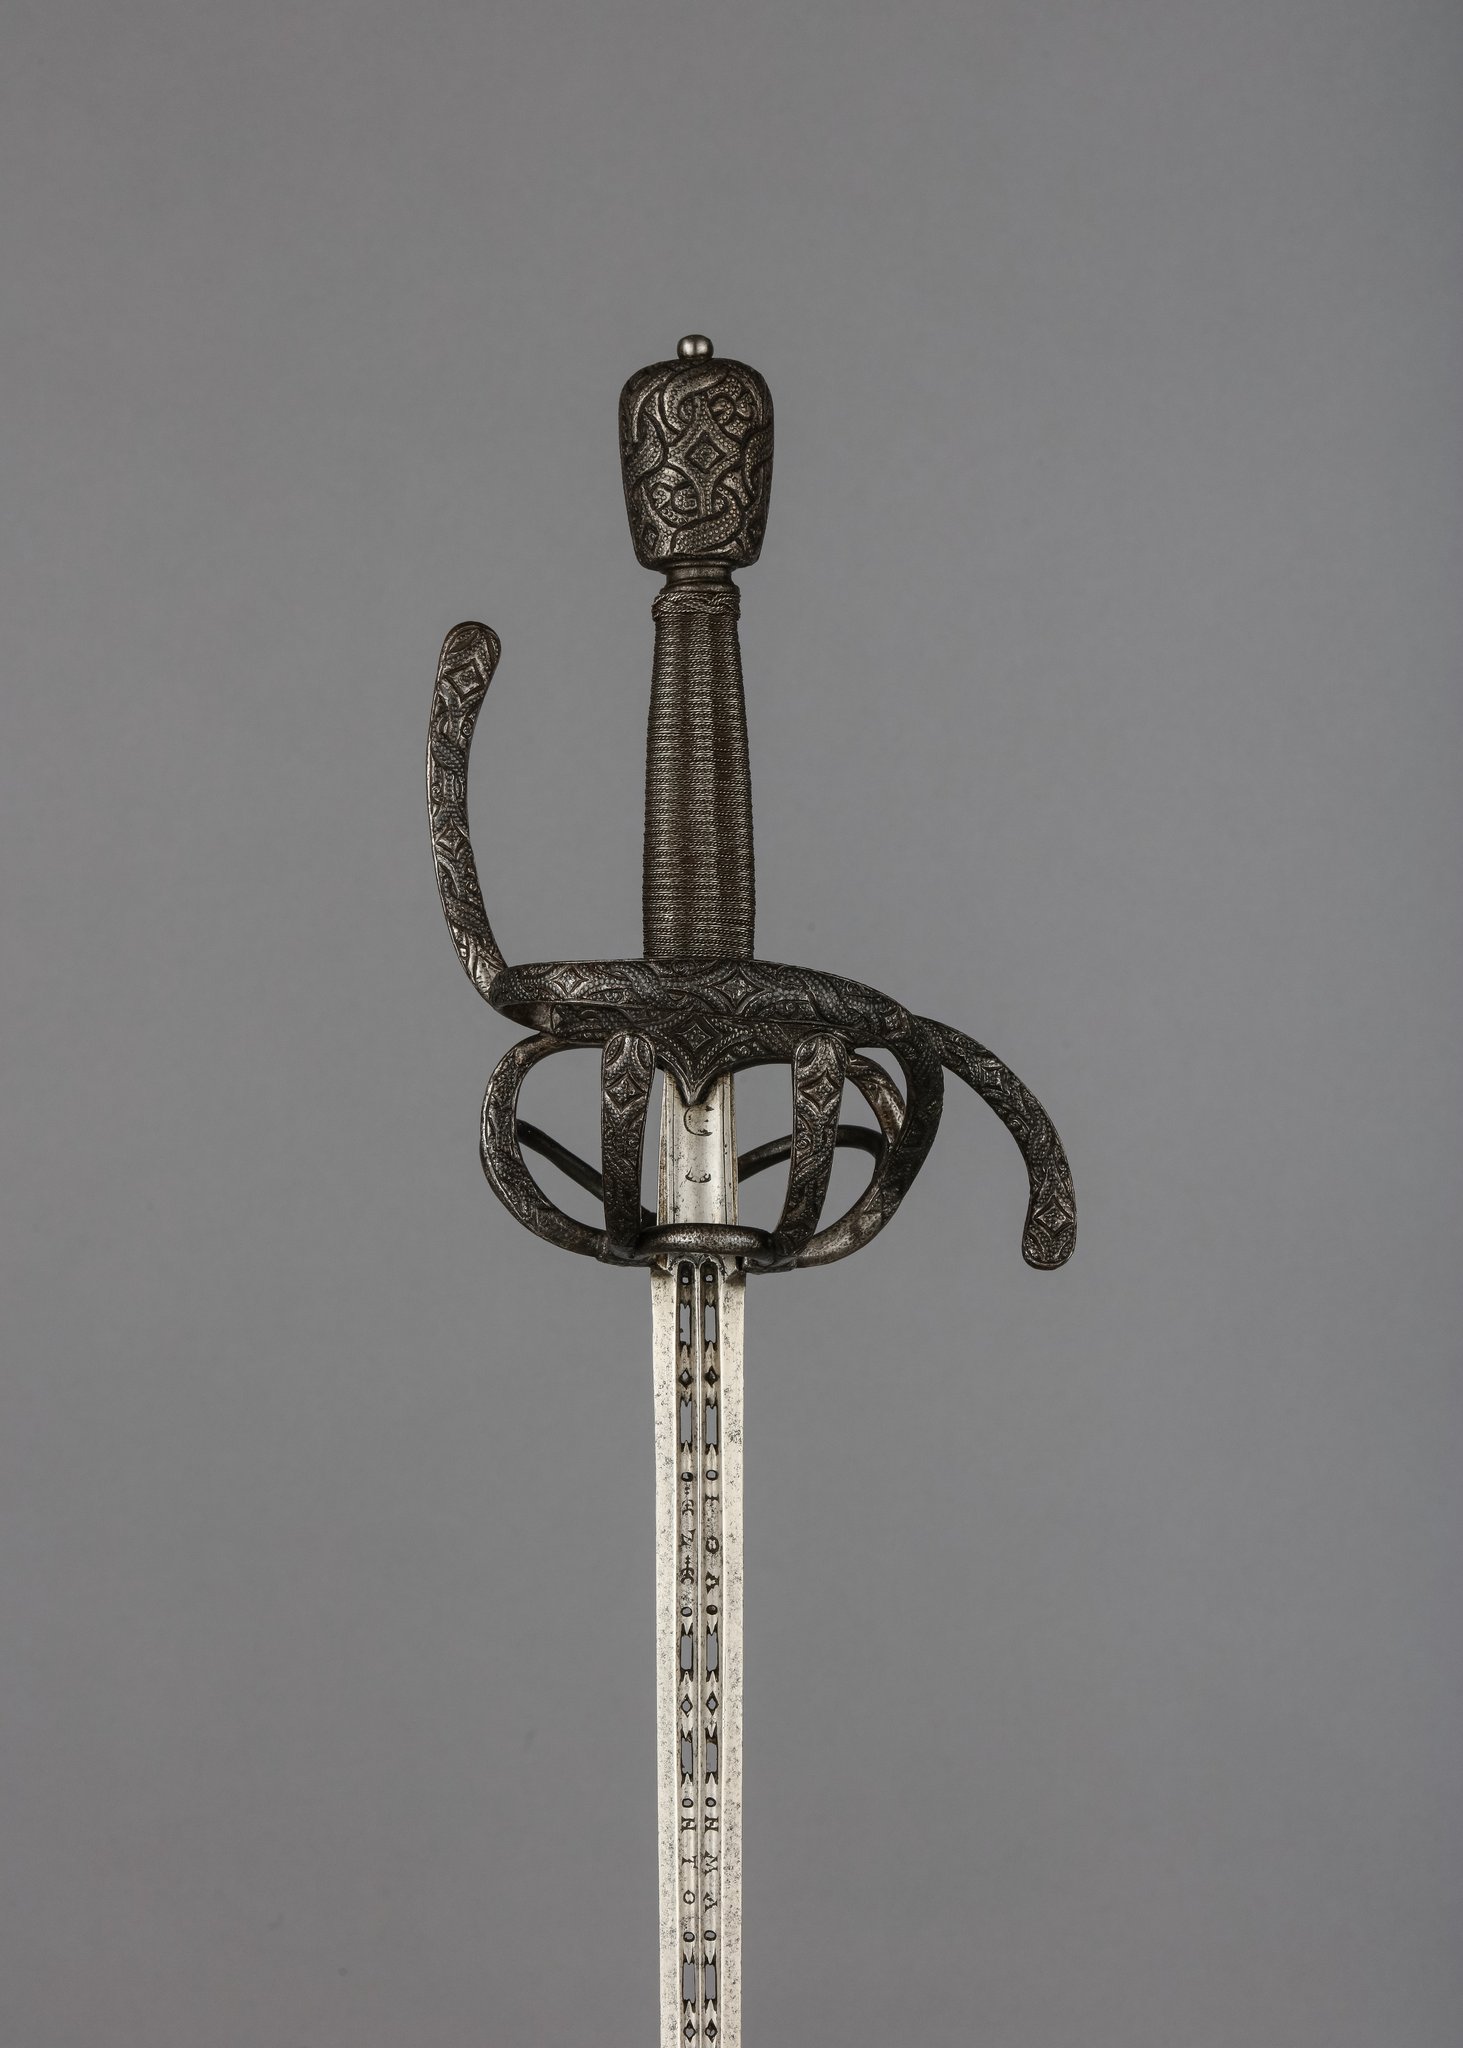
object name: rapier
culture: german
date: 1501-1600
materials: iron, silver, steel, metal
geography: germany